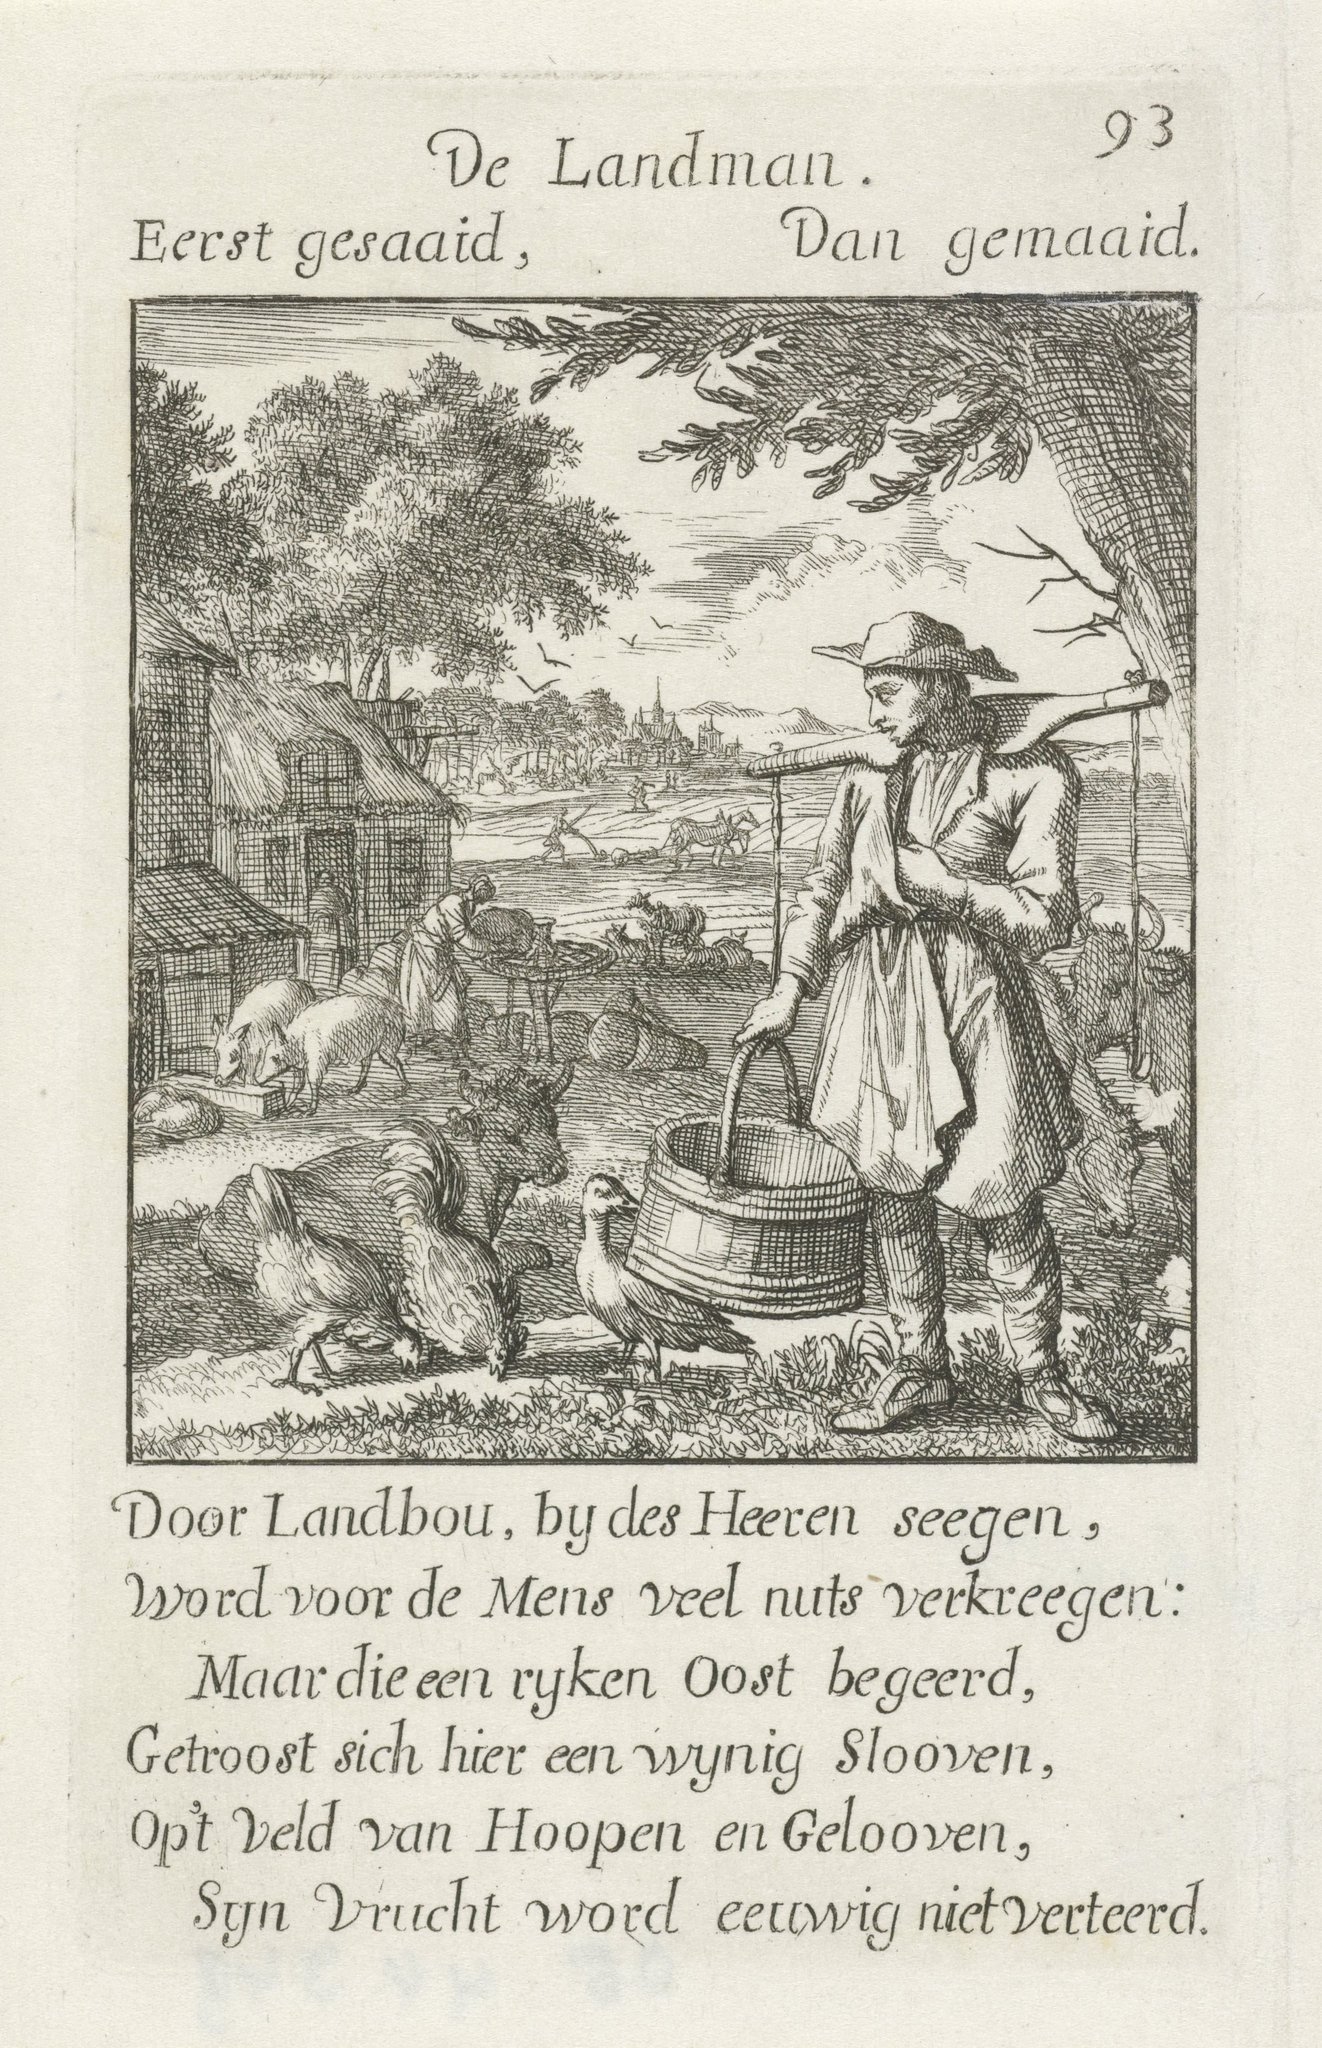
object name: print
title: Het Menselyk Bedryf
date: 1694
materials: paper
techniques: etching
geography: amsterdam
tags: farmers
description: Maakt deel uit van de 100-delige serie beroepsprenten van Jan en Caspar Luyken, getiteld: Het menselyk bedryf. S.l.s.n., 1694 (eerste druk).